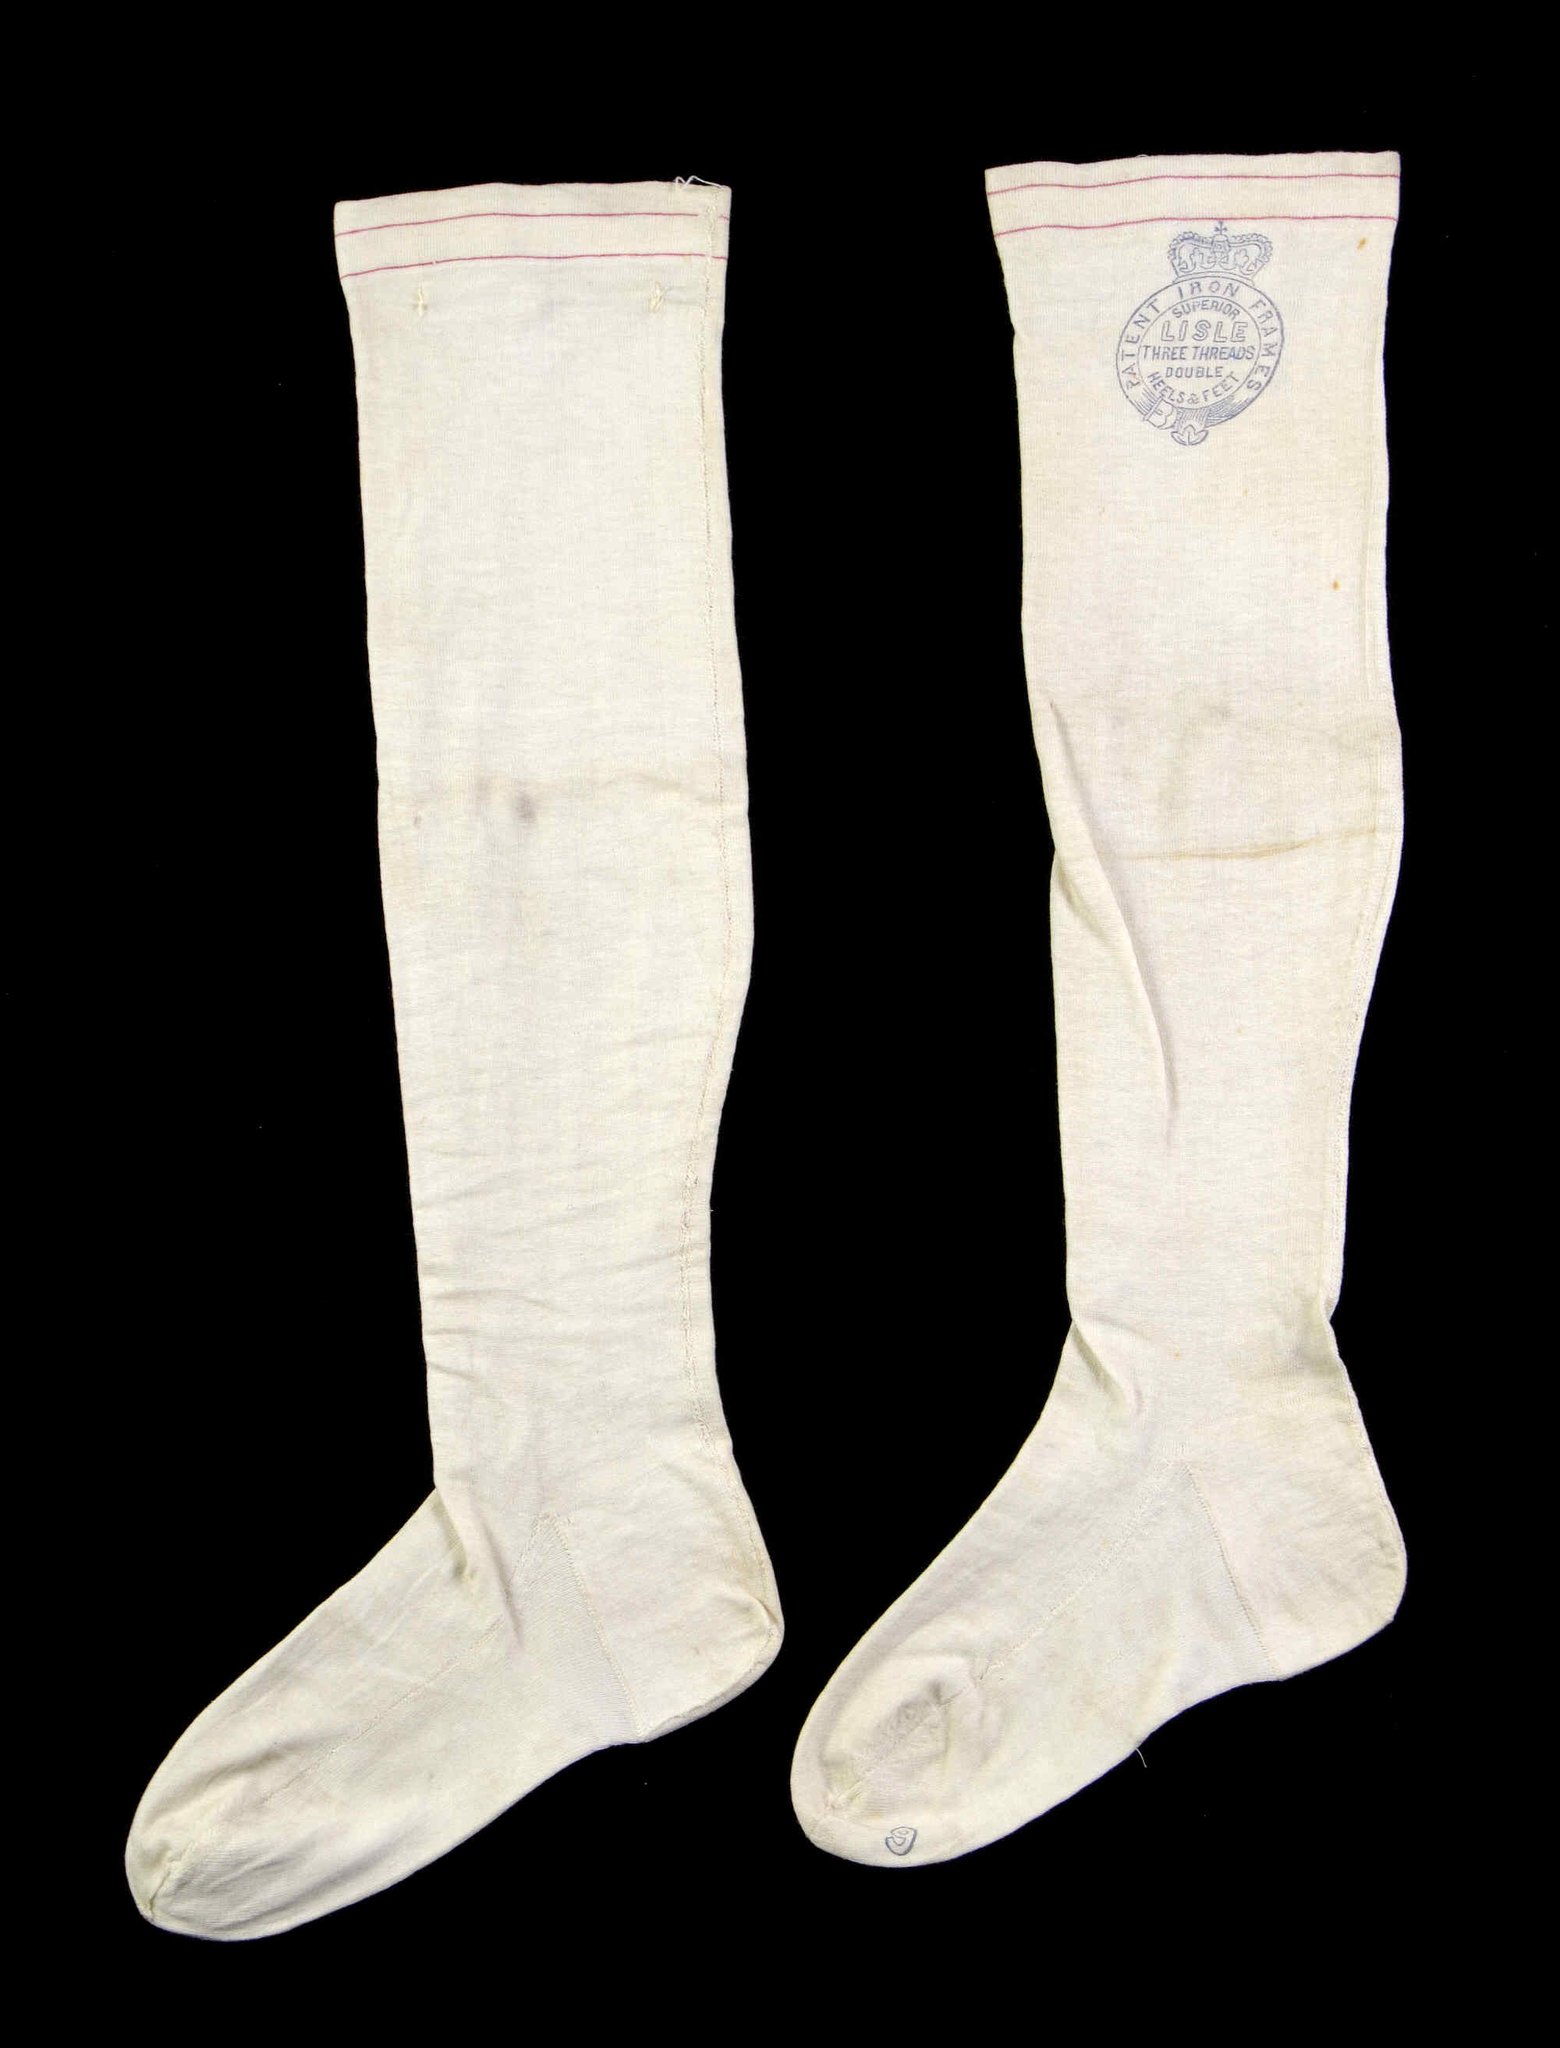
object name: stocking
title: Stockings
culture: american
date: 1851-1875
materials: cotton